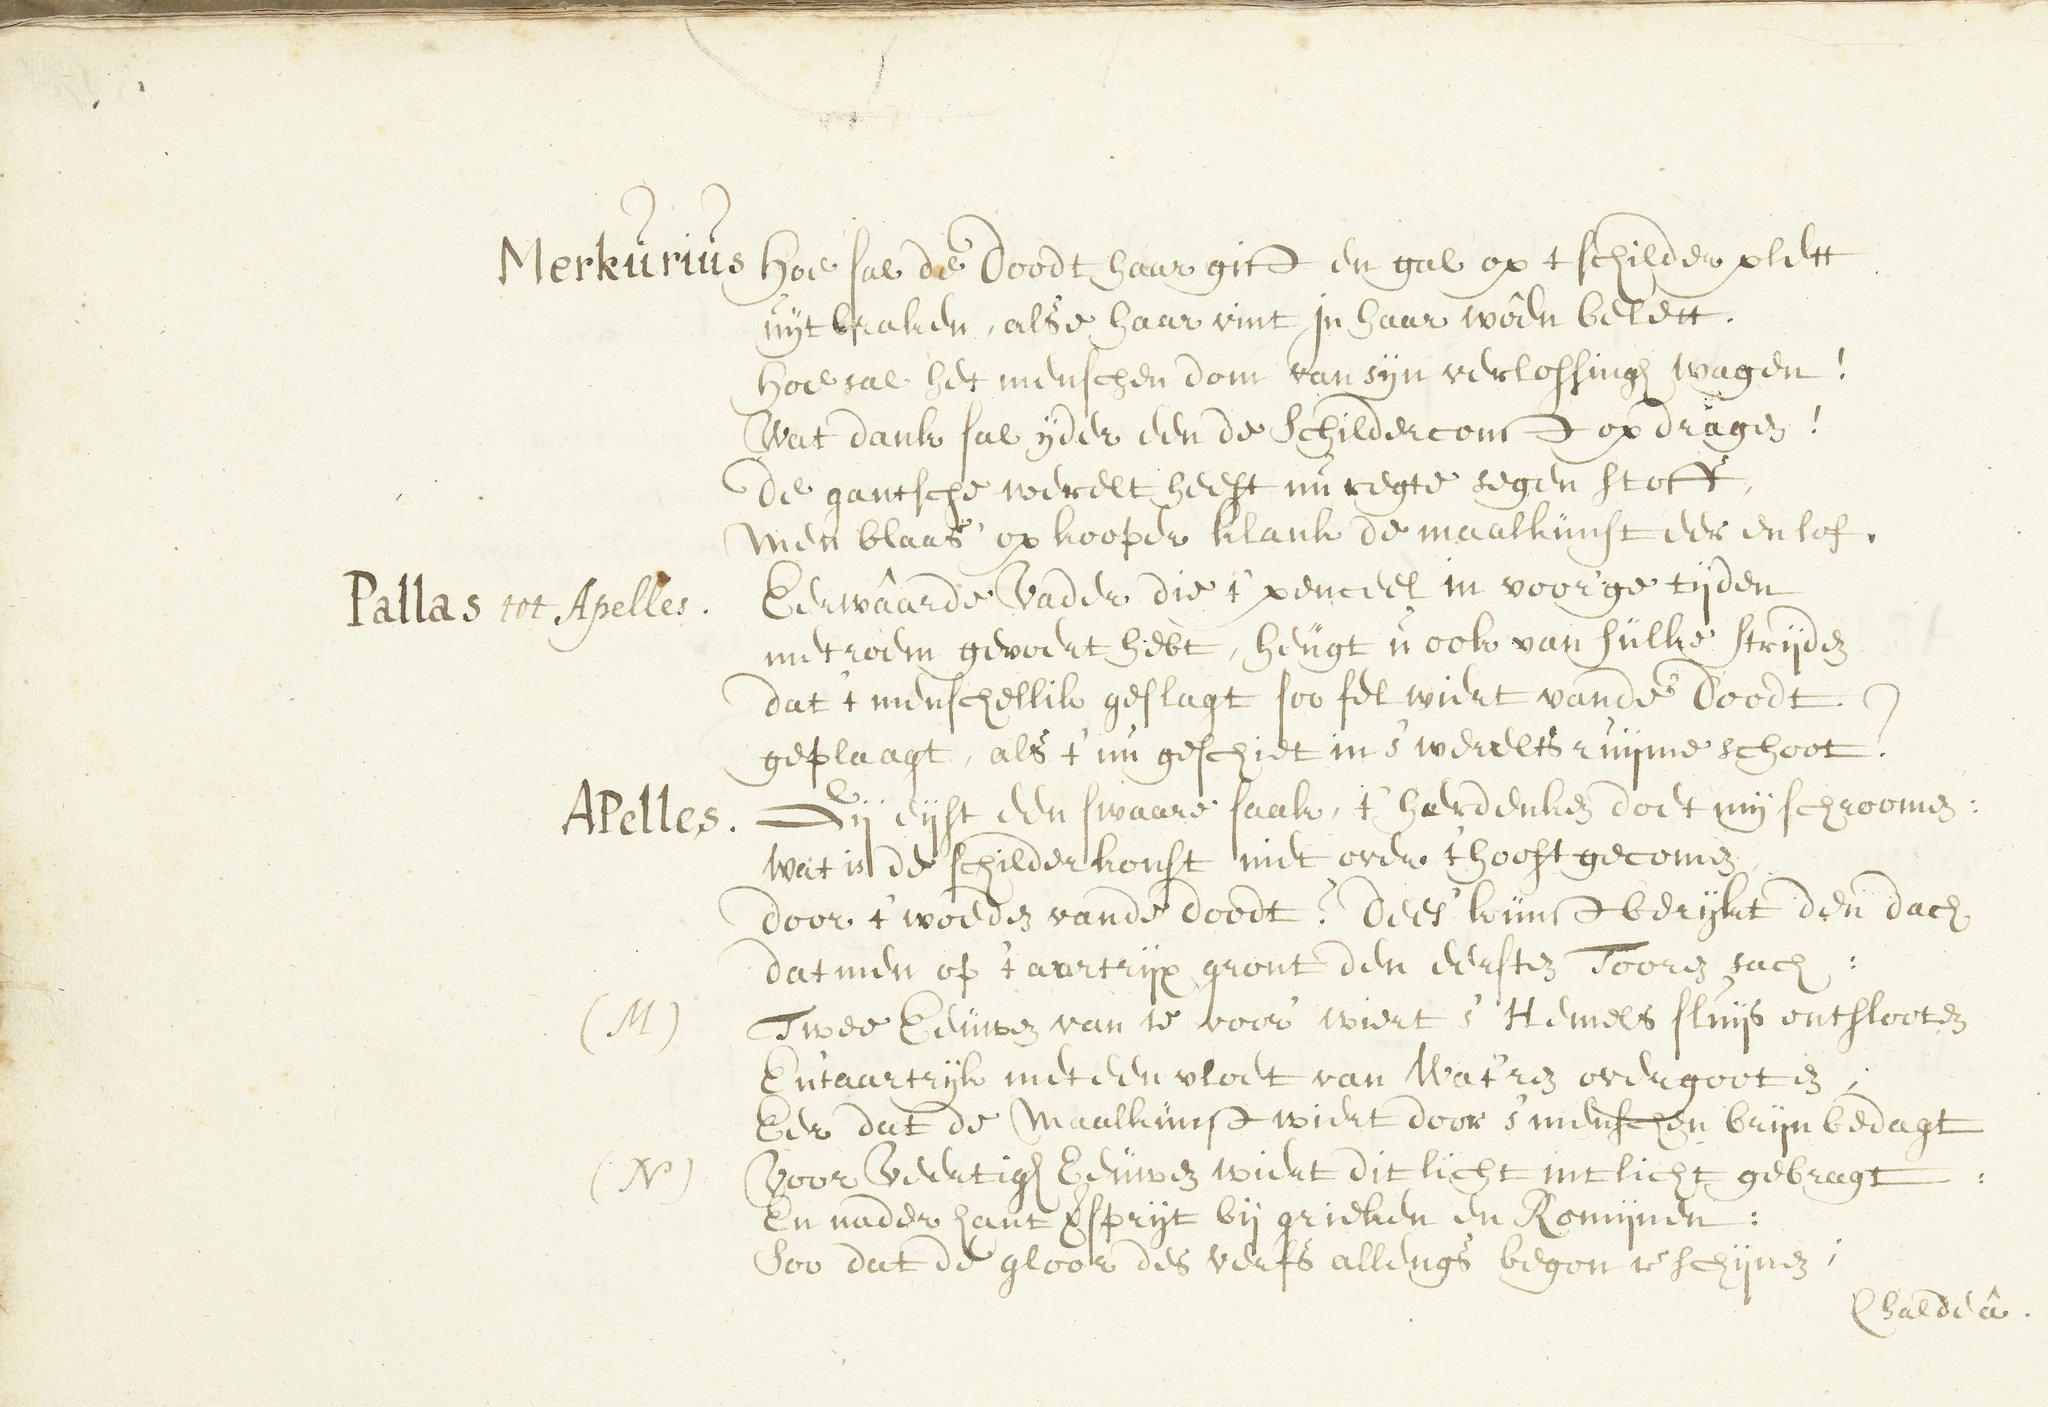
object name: text sheet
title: Strijd tussen Dood en Natuur of Zege der Schilderkunst (deel 18)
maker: henrik jordis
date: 1660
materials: ink, paper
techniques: writing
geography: zwolle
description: Vervolg van het toneelstuk Gooden Pleijdt ofte Triomphe der Schilderconst over de Doodt. In het toneelstuk beraden Apollo, Mercurius, Pallas Athene en Natuur zich over de manier waarop de Dood overwonnen kan worden en roepen zij de hulp van Schilderkunst in.